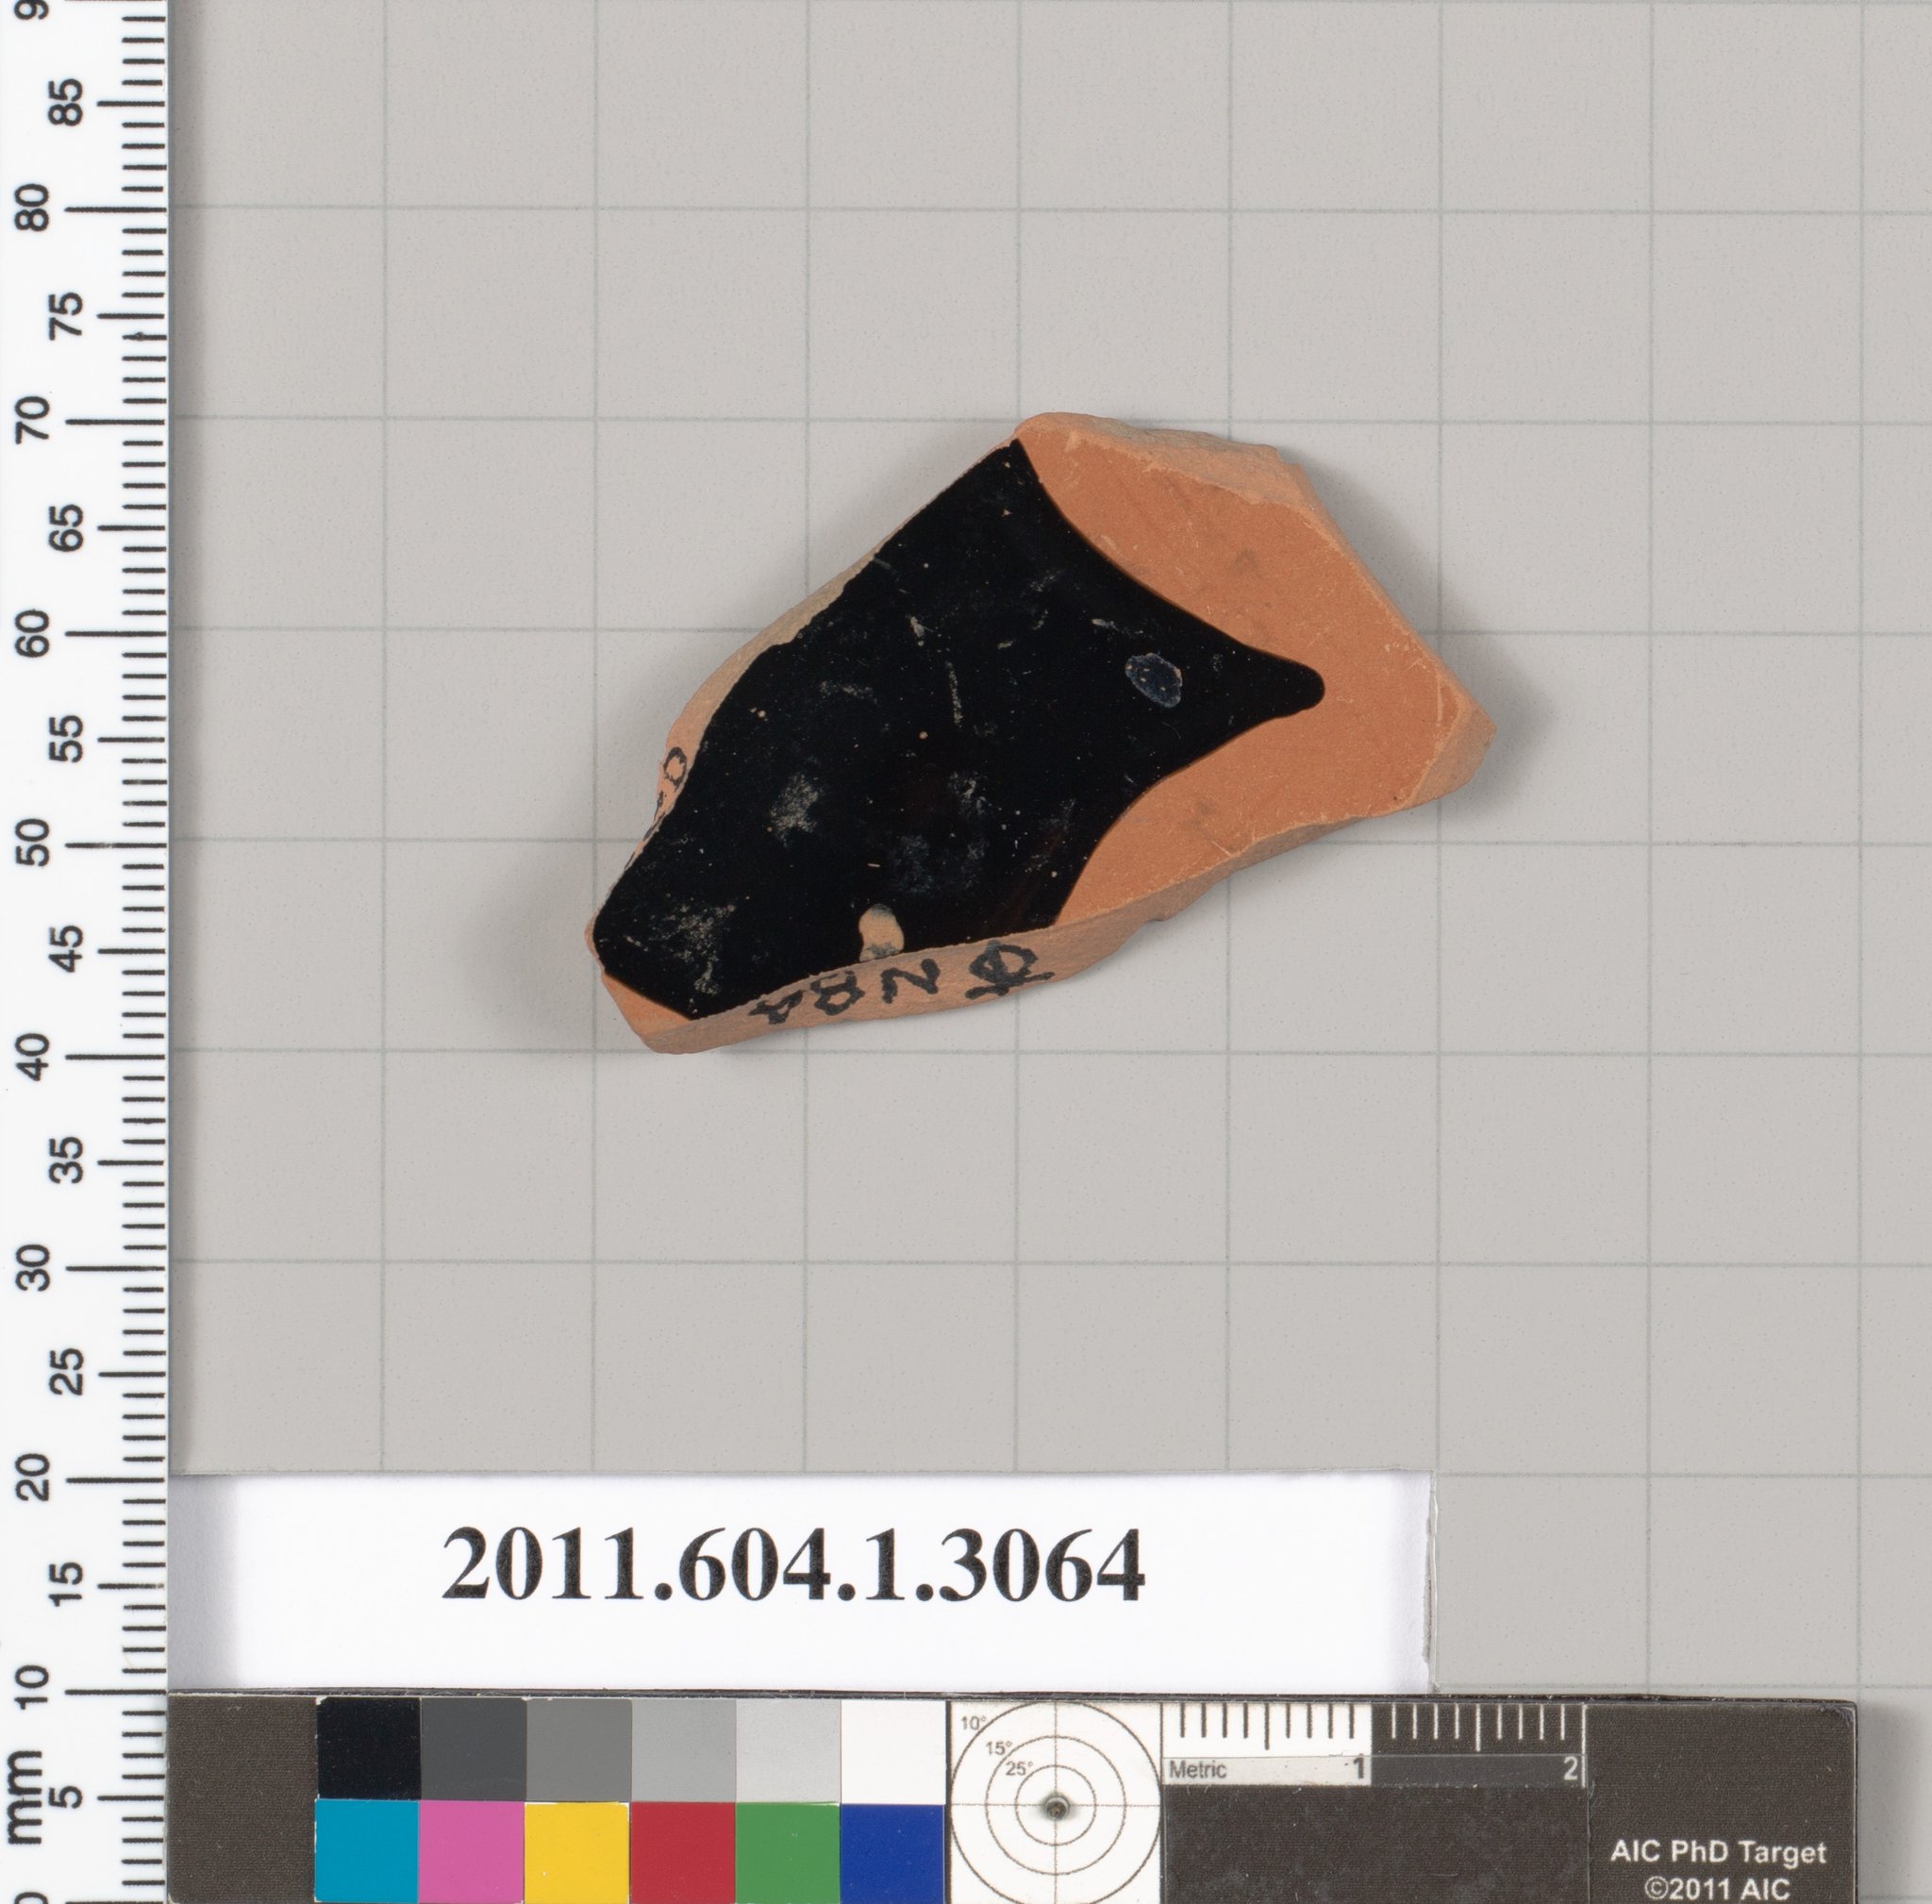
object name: kylix fragment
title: Terracotta fragment of a kylix (drinking cup)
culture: greek, attic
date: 500-476 BCE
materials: terracotta